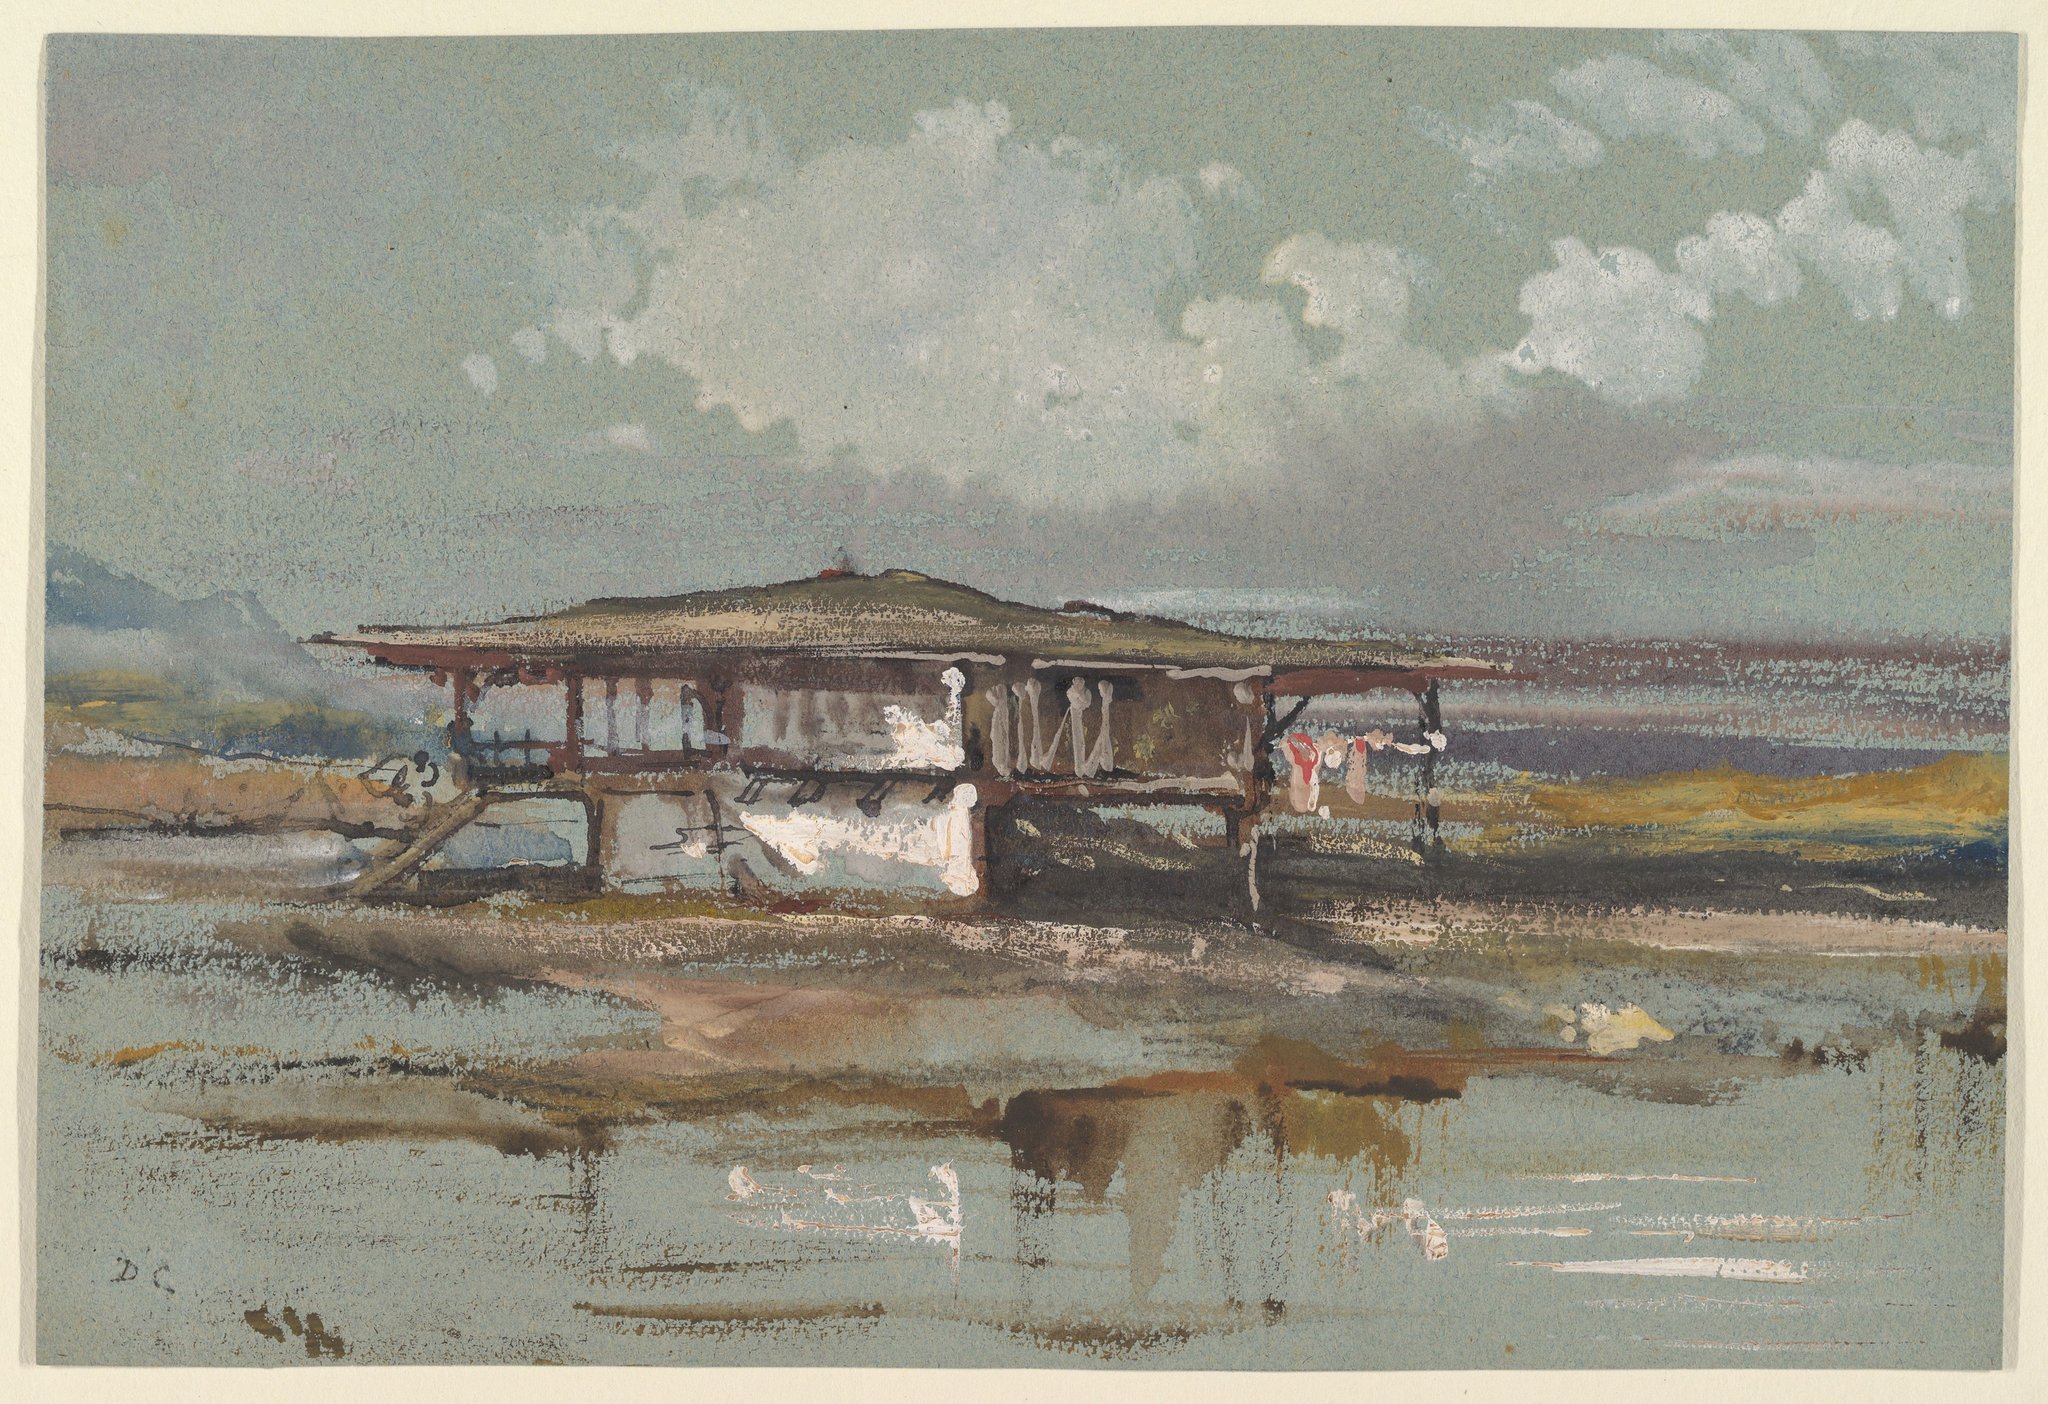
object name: drawing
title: A House in Turkey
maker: alexandre-gabriel decamps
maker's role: artist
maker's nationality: french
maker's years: 1803-1860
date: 1820-1860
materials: chalk, ink, watercolor, paper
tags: houses